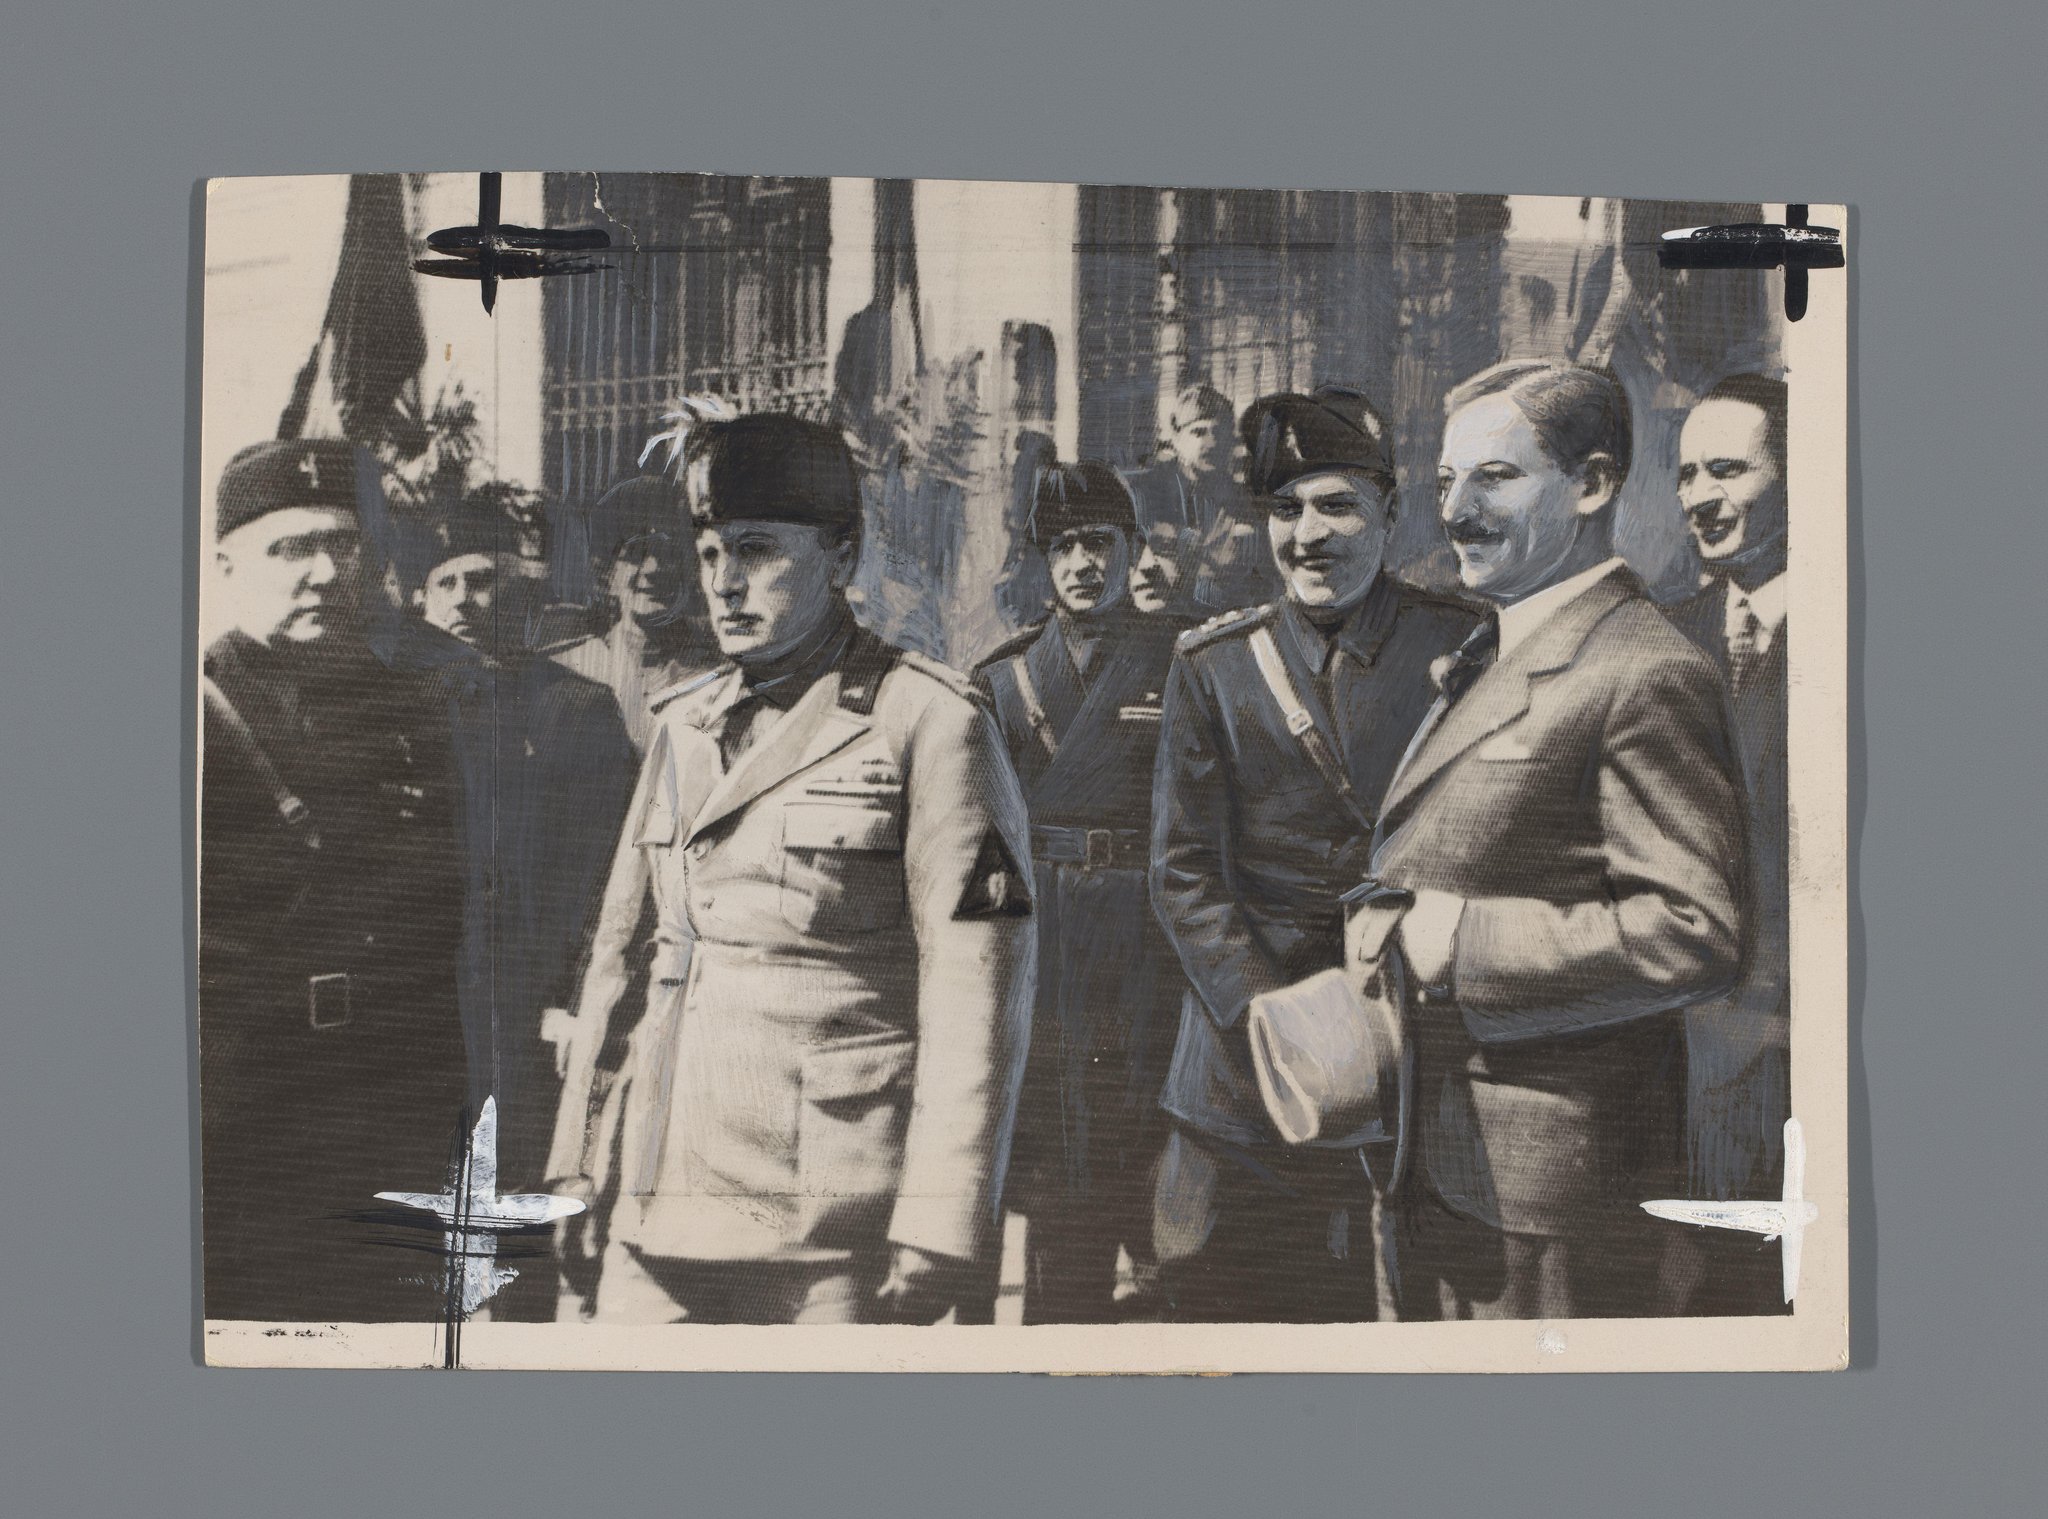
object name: photograph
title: Benito Mussolini met Kurt Schuschnigg in Venetië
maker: Anonymous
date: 1937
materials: ink, paper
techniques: printed materials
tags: politician, venice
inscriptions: inscription: ‘’LE CHANCELIER SCHUSCHNIGG A VENISE / Arrivé hier matin à Venise, le Chancelier d’Autriche a eu un long entretien avec le Duce. / M. Mussolini et le Compte Ciano accueillent M. Schuschnigg à Venise. / PAR TELEPHOTO. / 9/ET/23437 (Keystone)’, inscription: ‘Mussolini / et Schuschnigg’